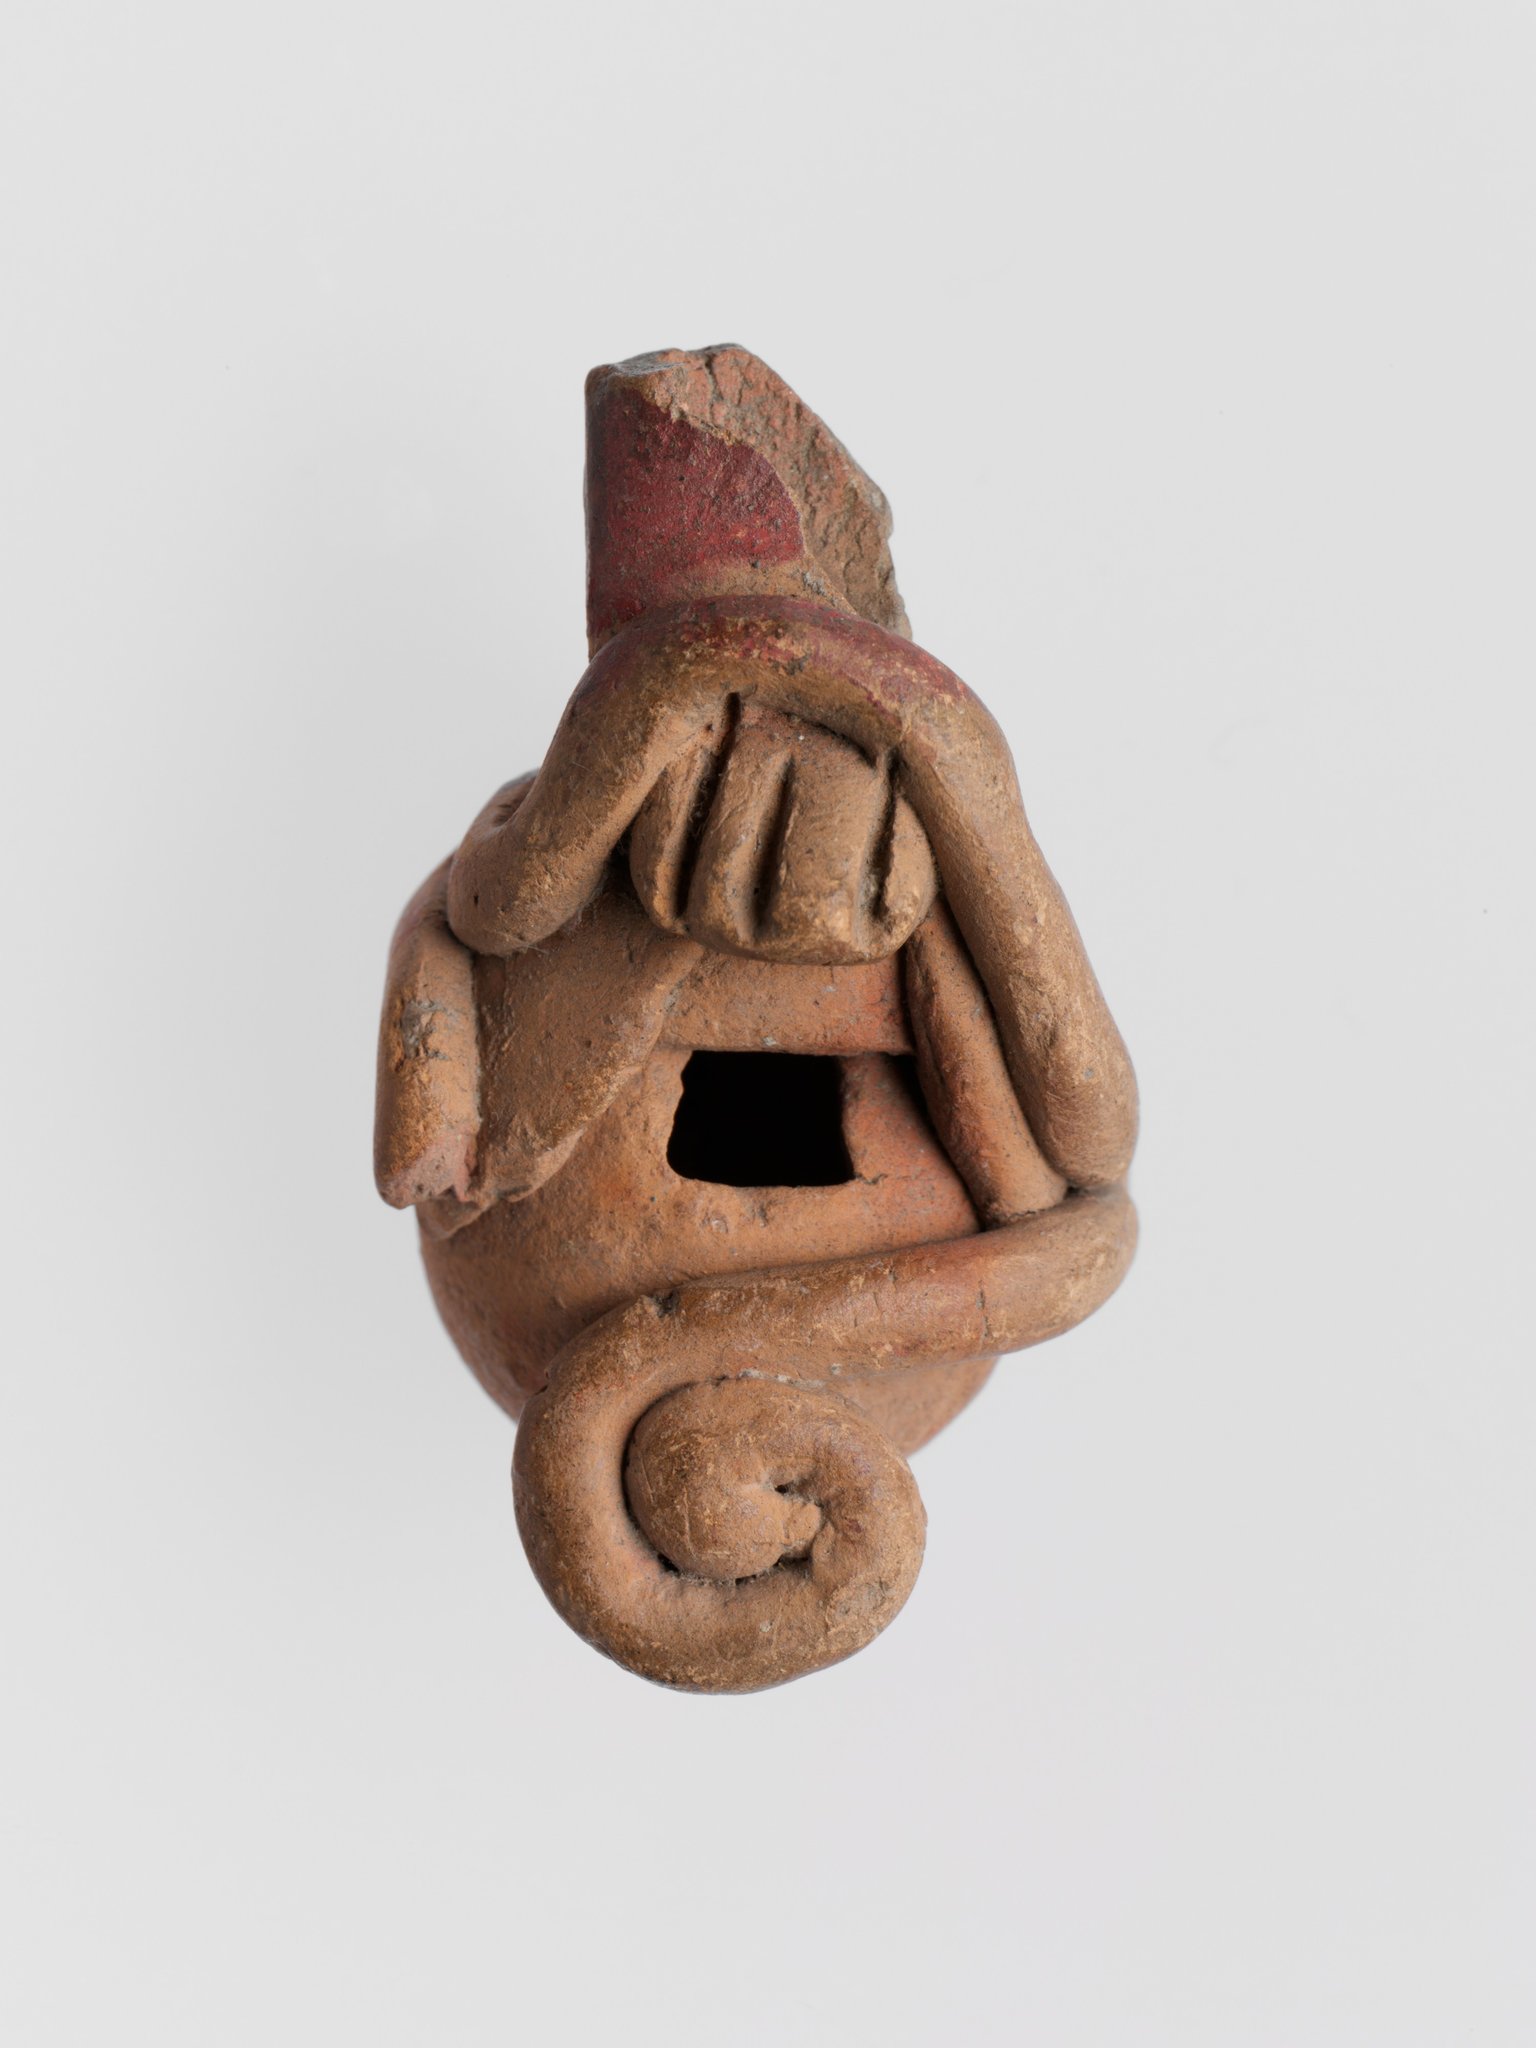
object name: pottery whistle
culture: mexican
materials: clay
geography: mexico